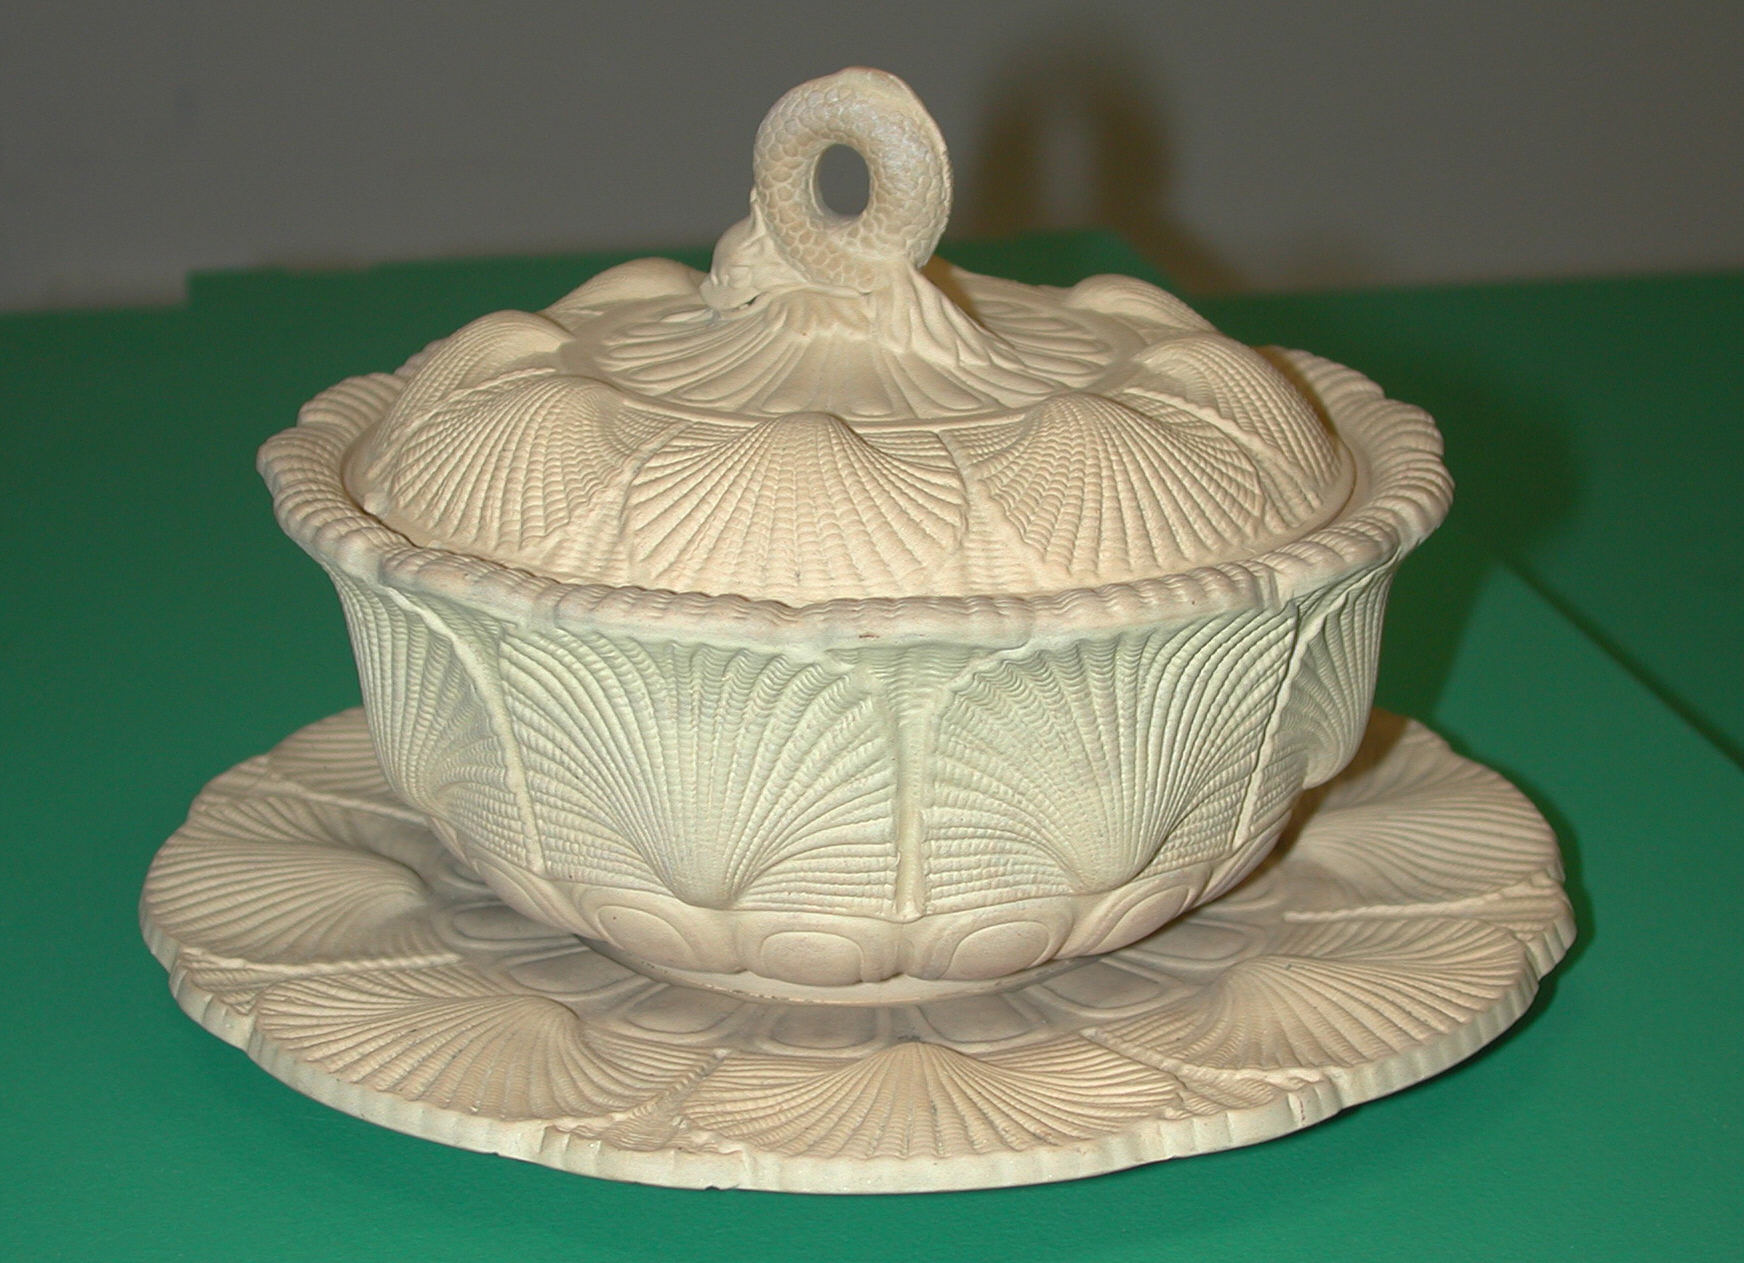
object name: butter cooler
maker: w s & s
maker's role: factory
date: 1860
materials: stoneware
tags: shells